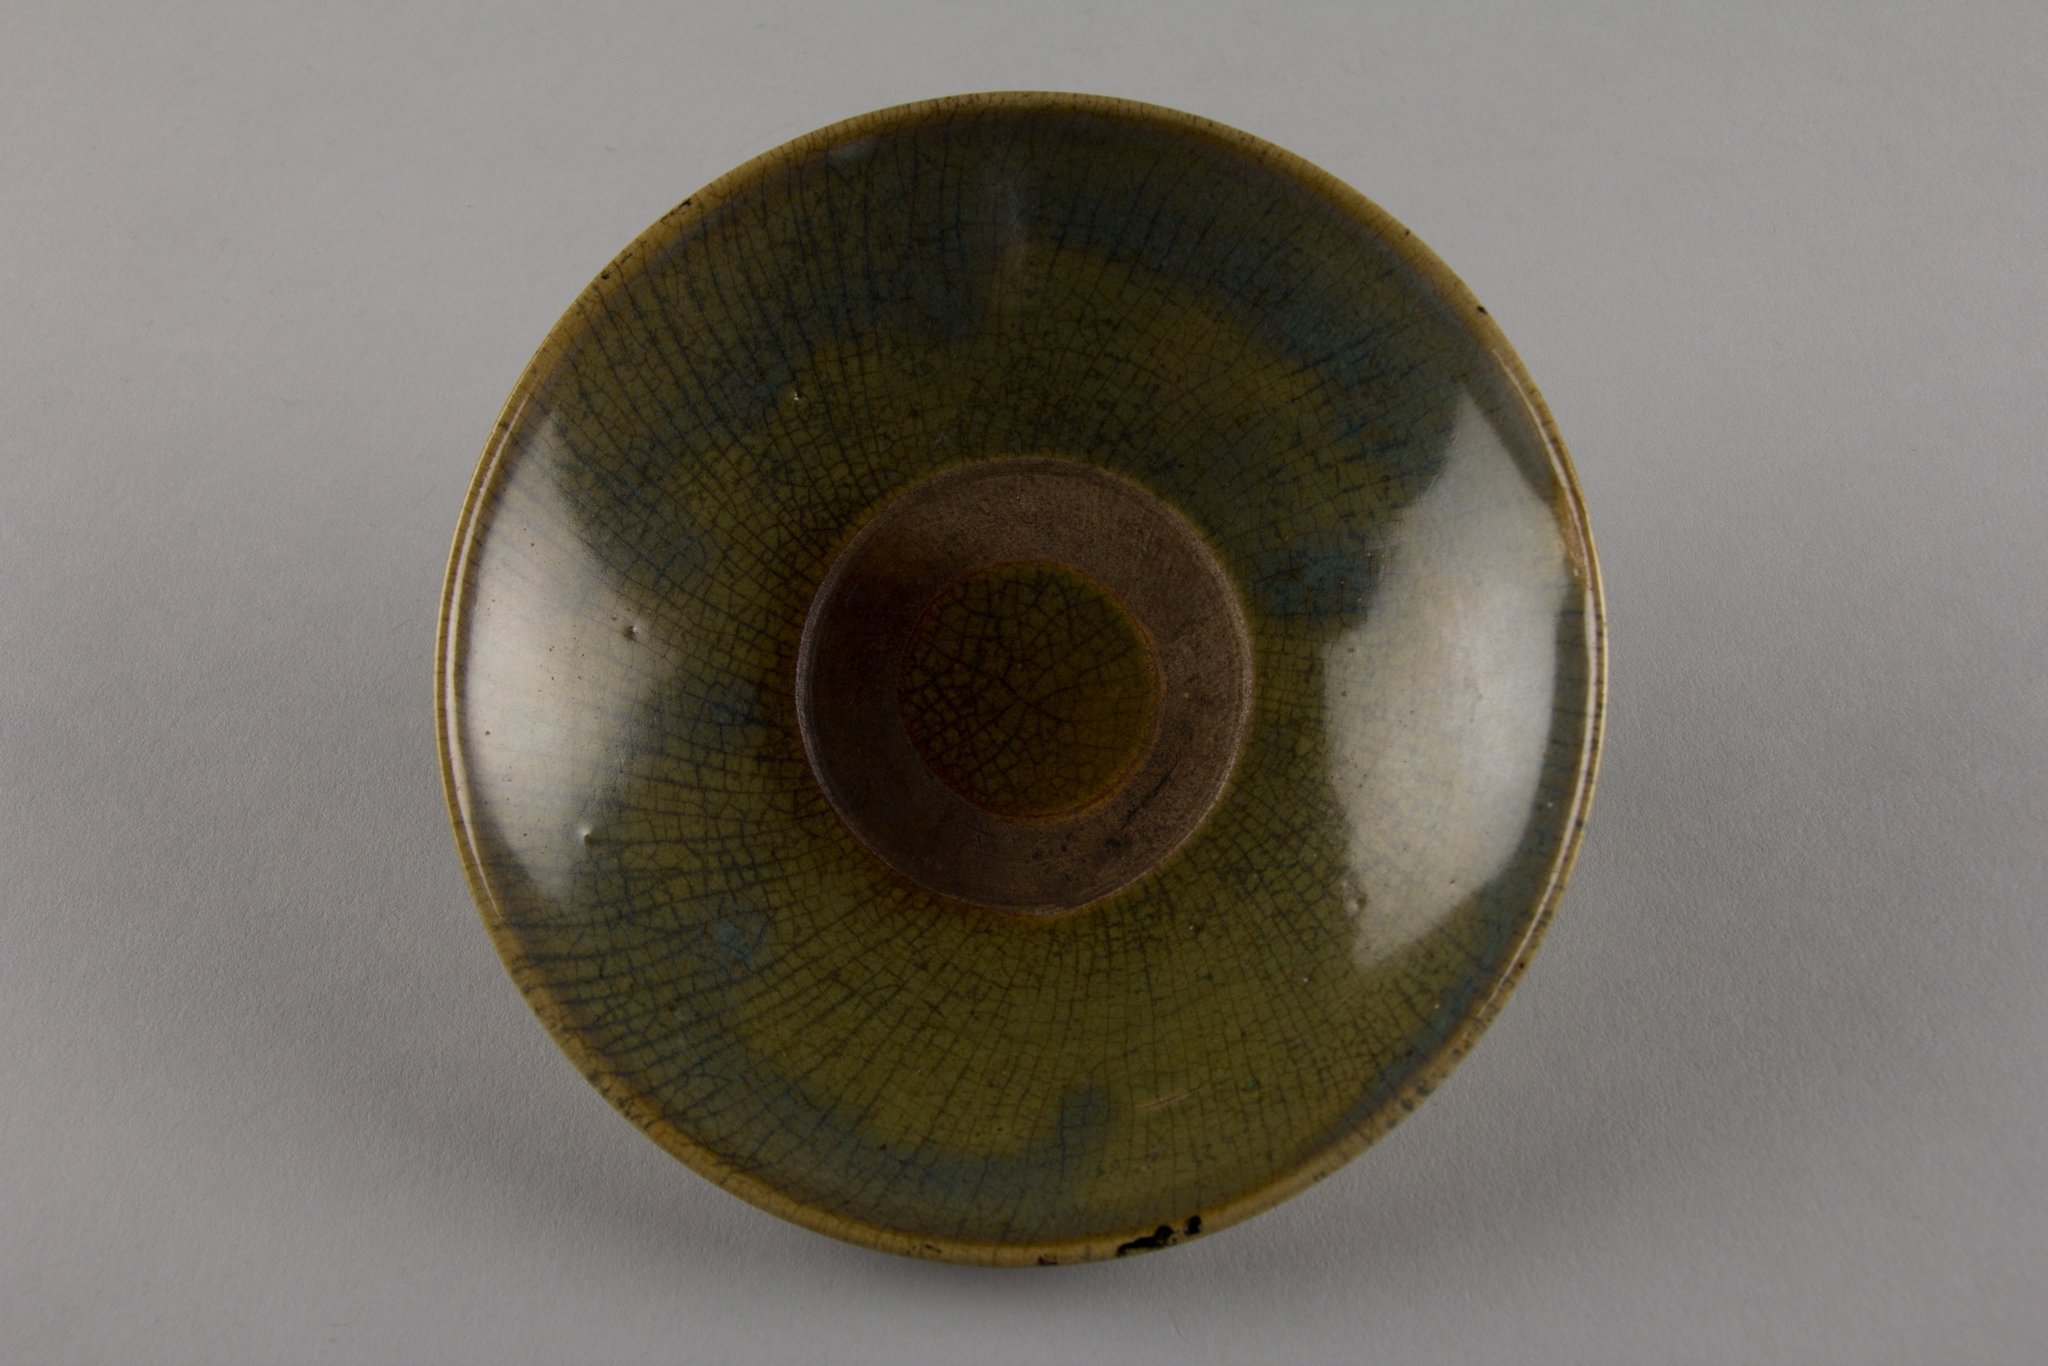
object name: dish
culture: chinese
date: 1701-1800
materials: glaze, stoneware